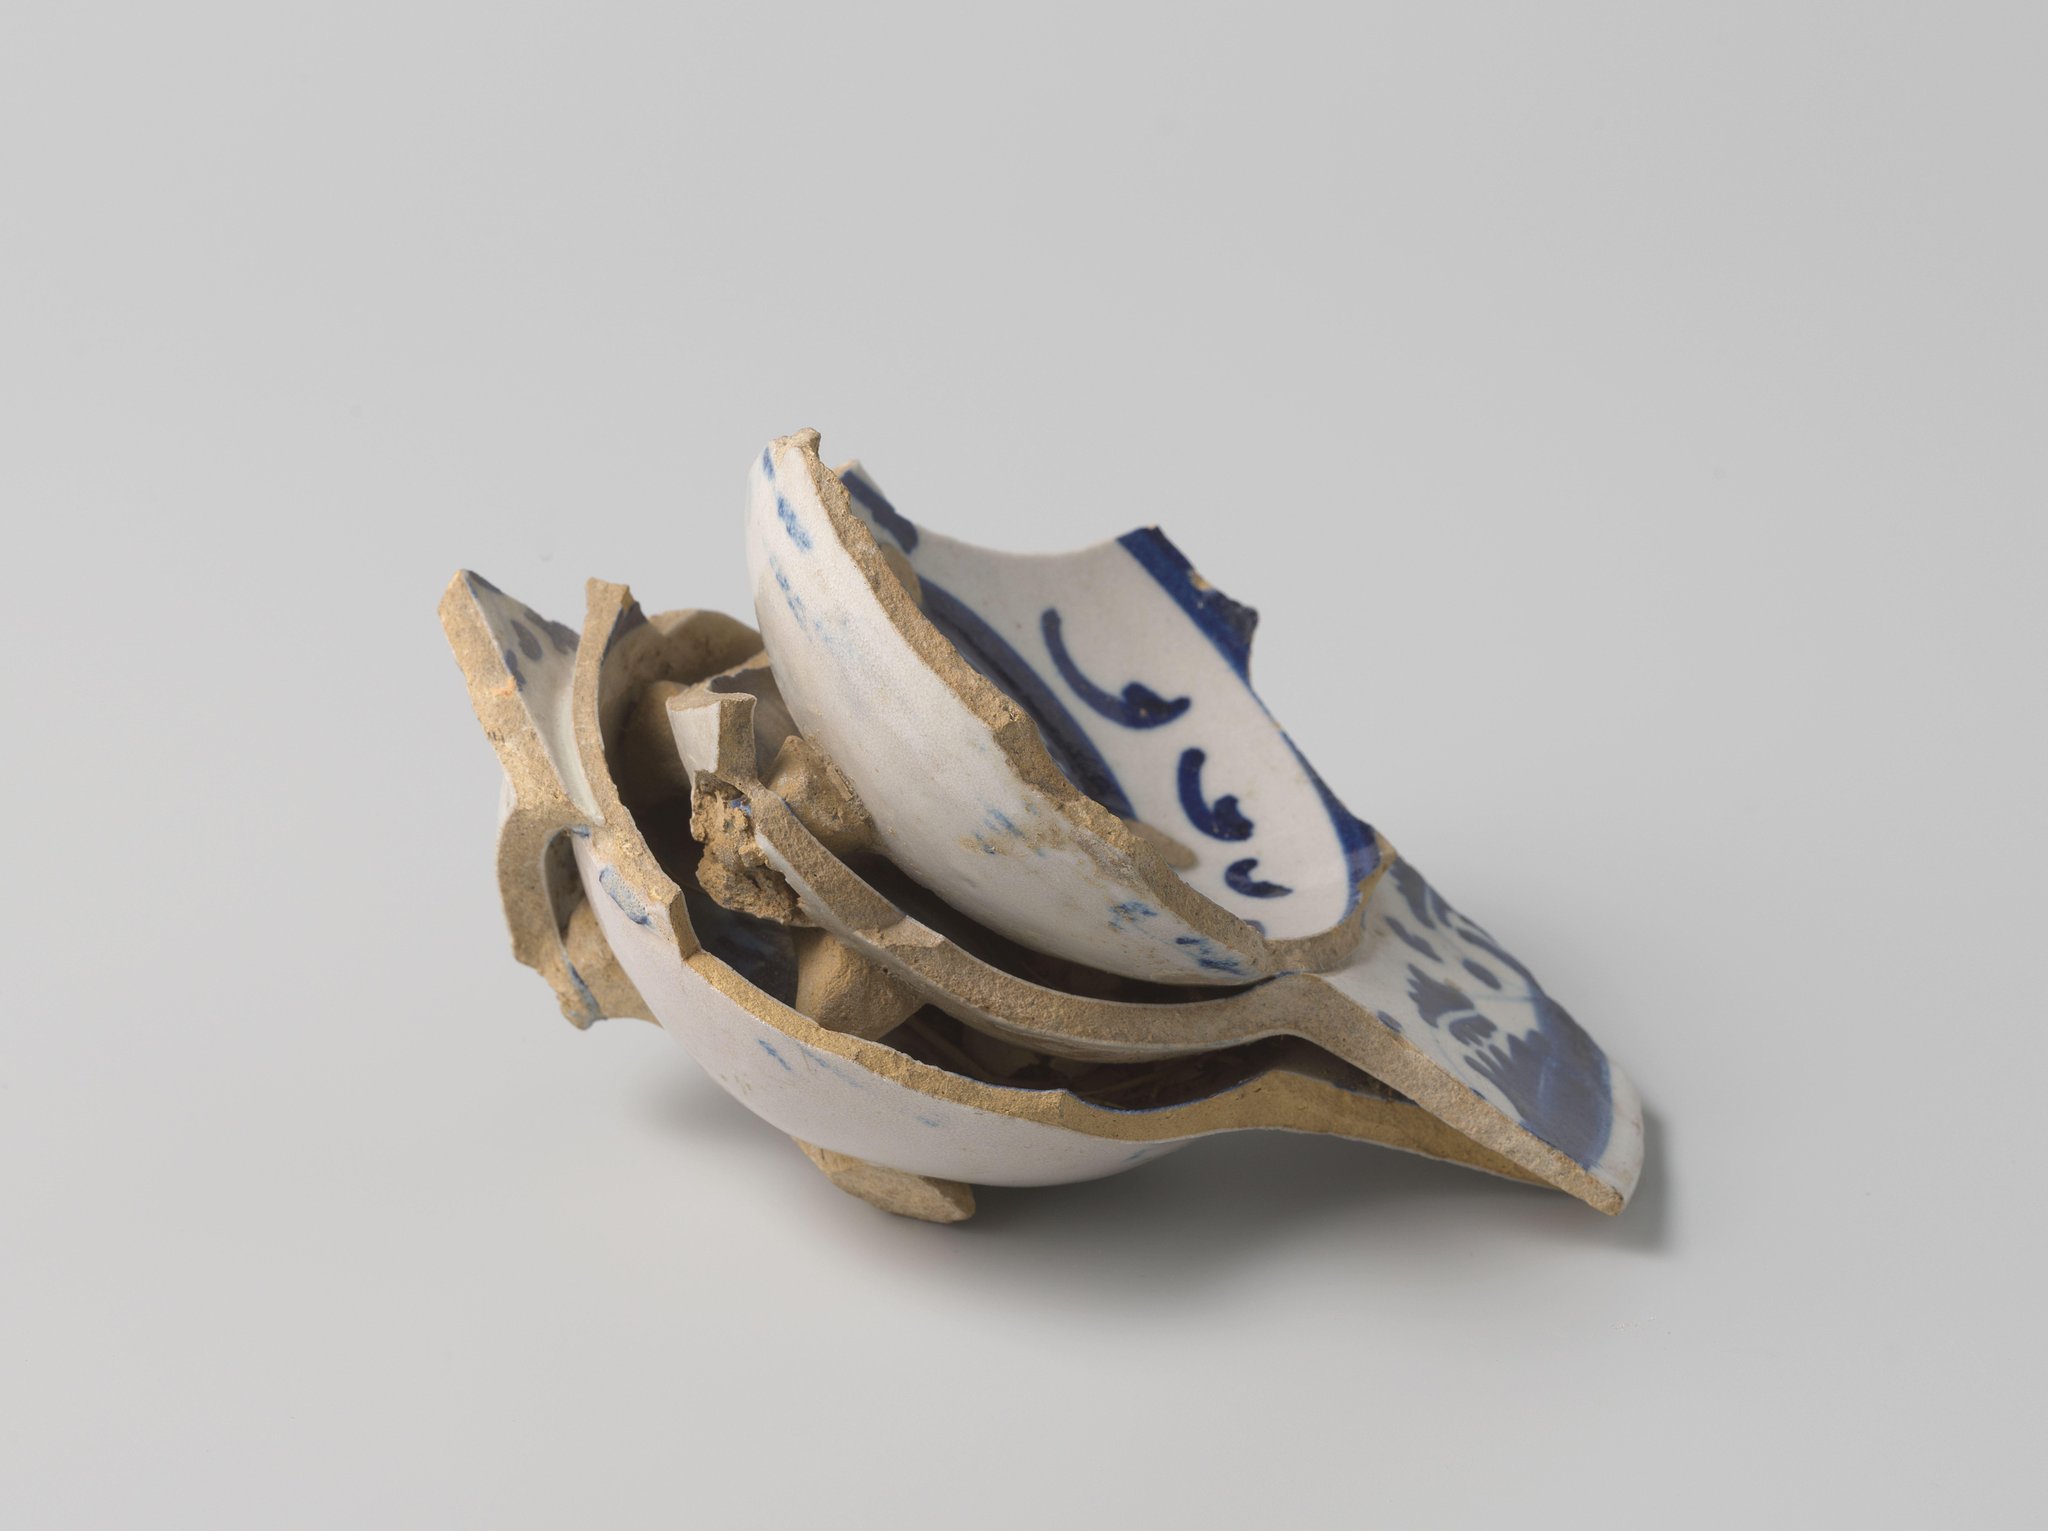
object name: sherd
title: Misbaksel met proenen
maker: Anonymous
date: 1200-1899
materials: earthenware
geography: italy